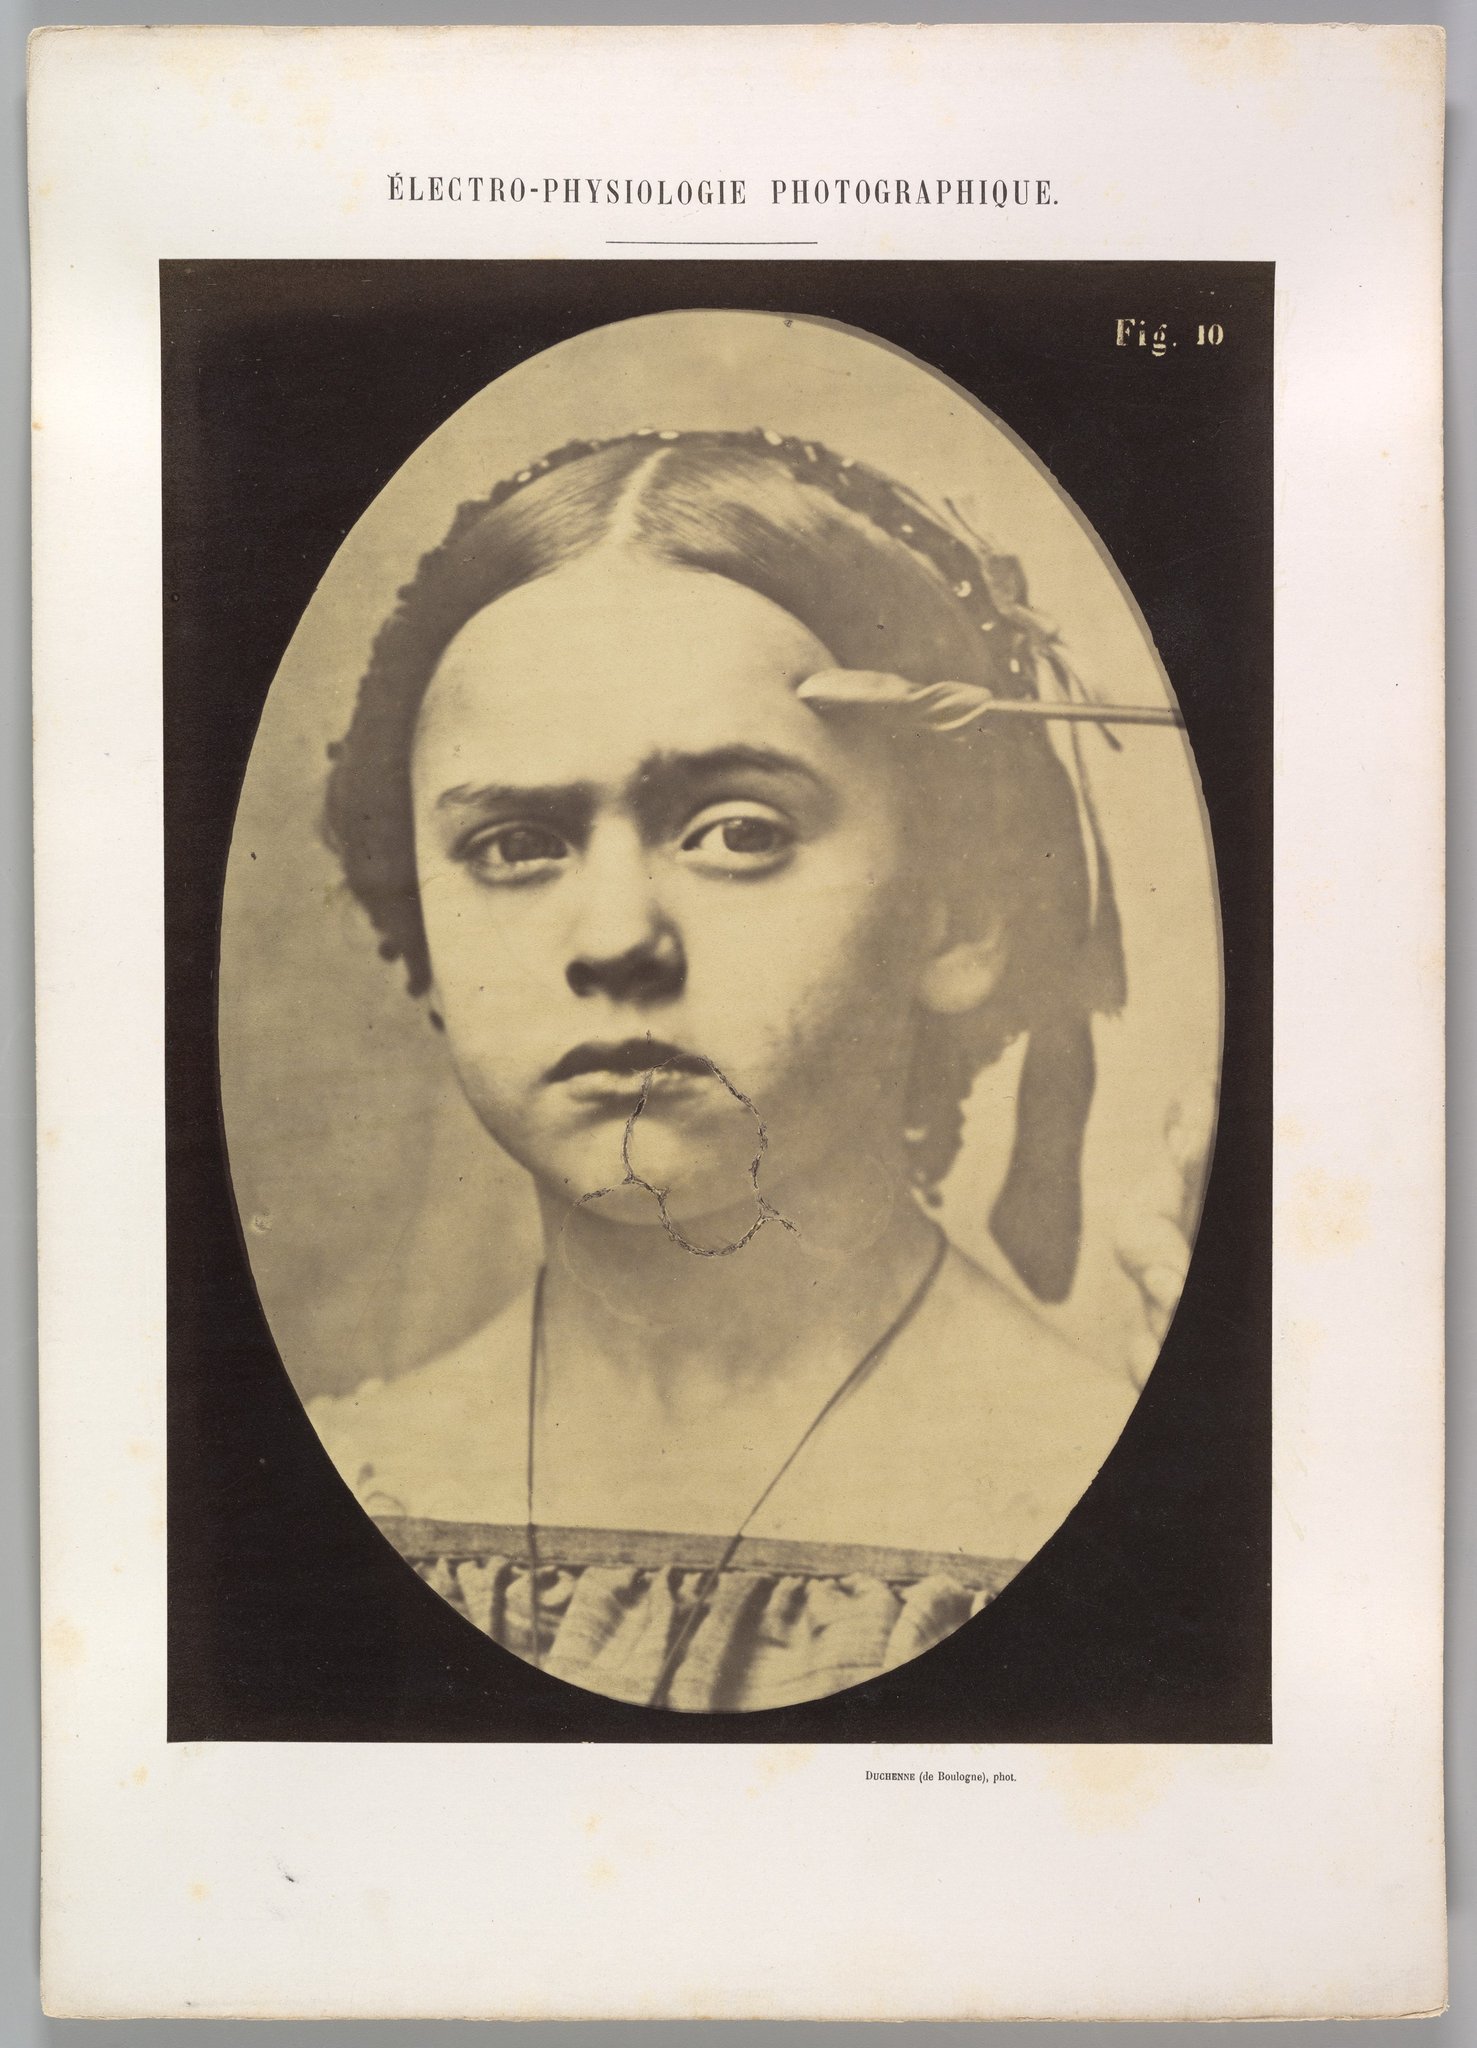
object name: photograph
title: Figure 10: Showing the expressive lines of m. frontalis in a young girl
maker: guillaume-benjamin-amand duchenne de boulogne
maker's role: artist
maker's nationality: french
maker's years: 1806-1875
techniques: albumen silver print, glass negative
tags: girls,portraits